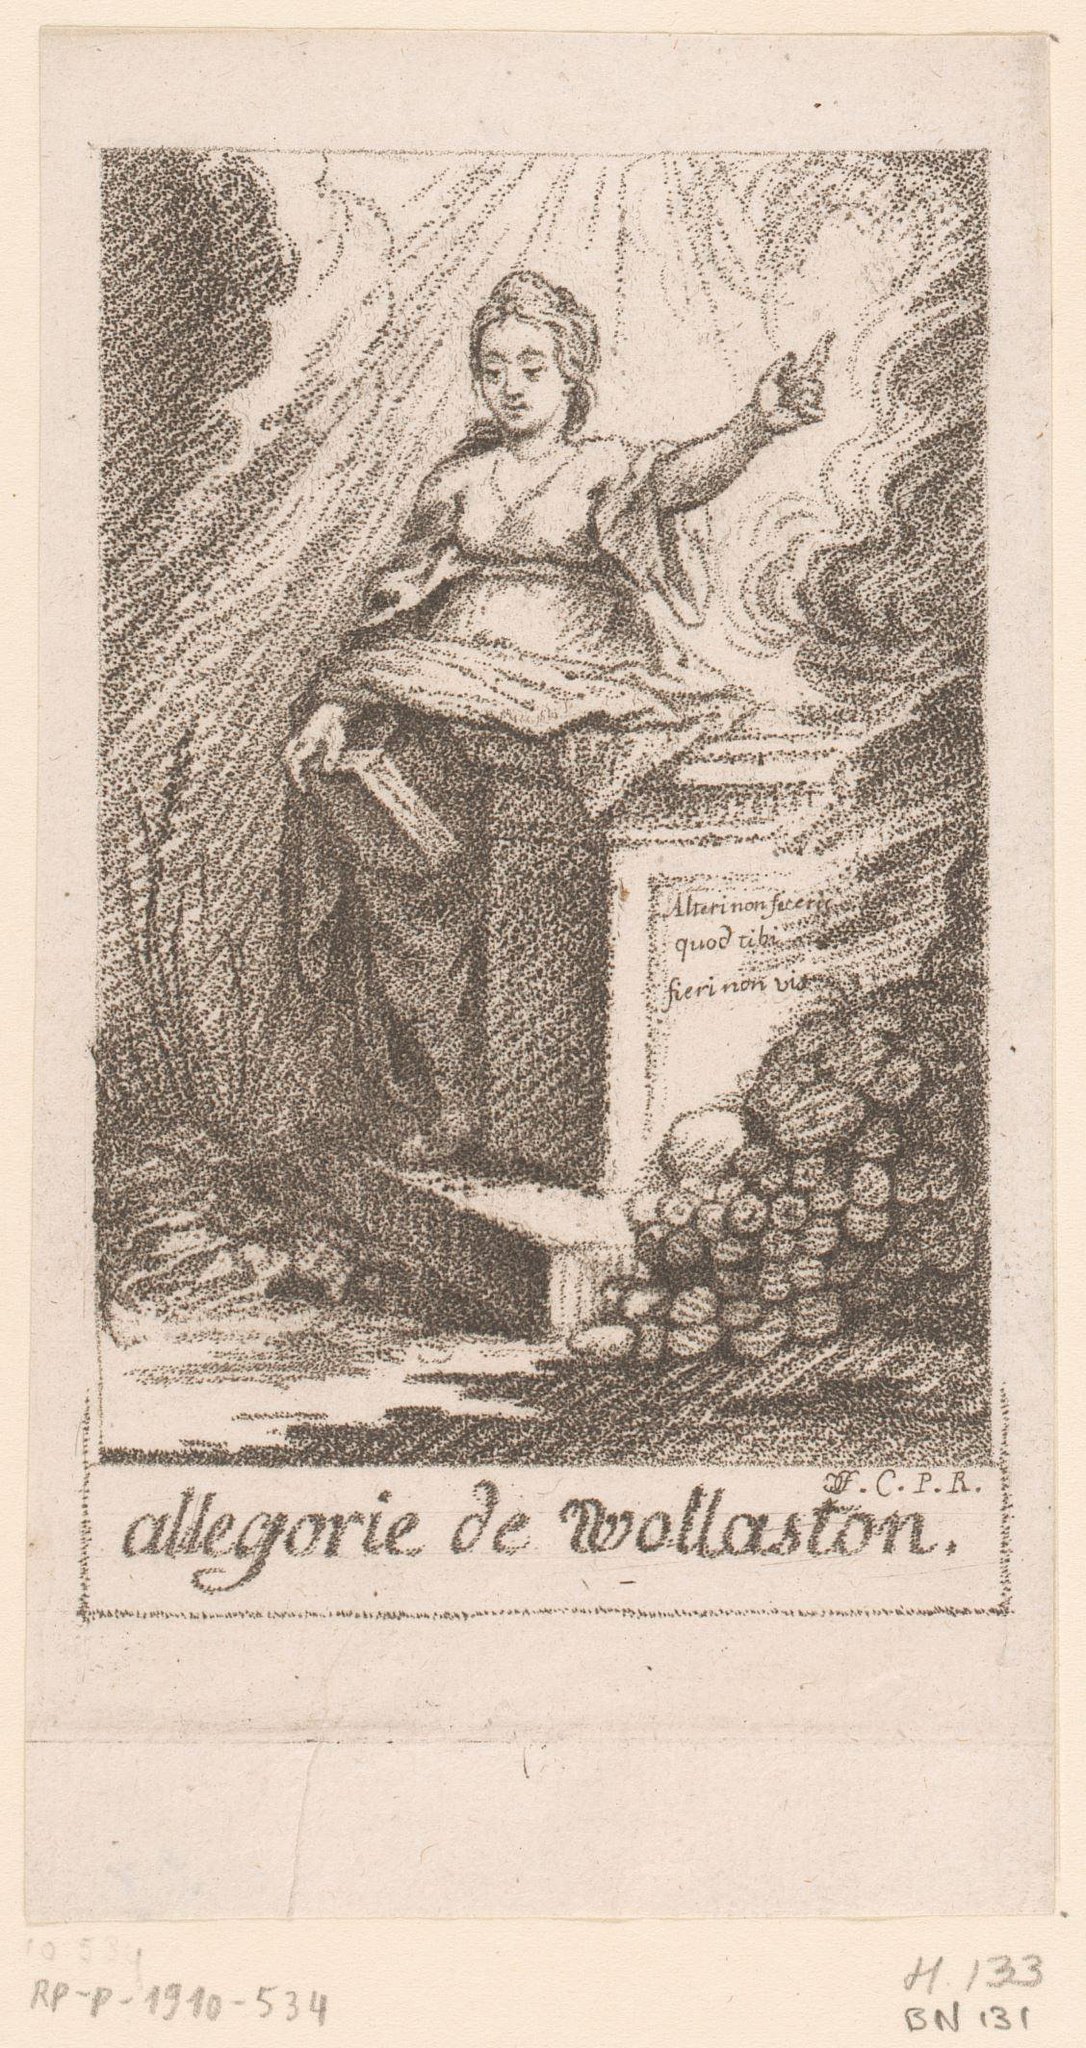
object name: book illustration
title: Allegorische voorstelling met wijzende vrouw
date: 1760-1769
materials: paper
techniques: printmaking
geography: france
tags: upright gravestone, sunbeams, index finger forwards, pointing, indicating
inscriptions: collector's mark: Lugt 2228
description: Prent uit: Saverien, Alexandre. L'Histoire des Philosophes modernes, avec leur portrait gravé dans le goût du crayon, d'apres les desseins des plus grands peintres. Parijs: Jean Charles François, 1760-1761, dl. 2.